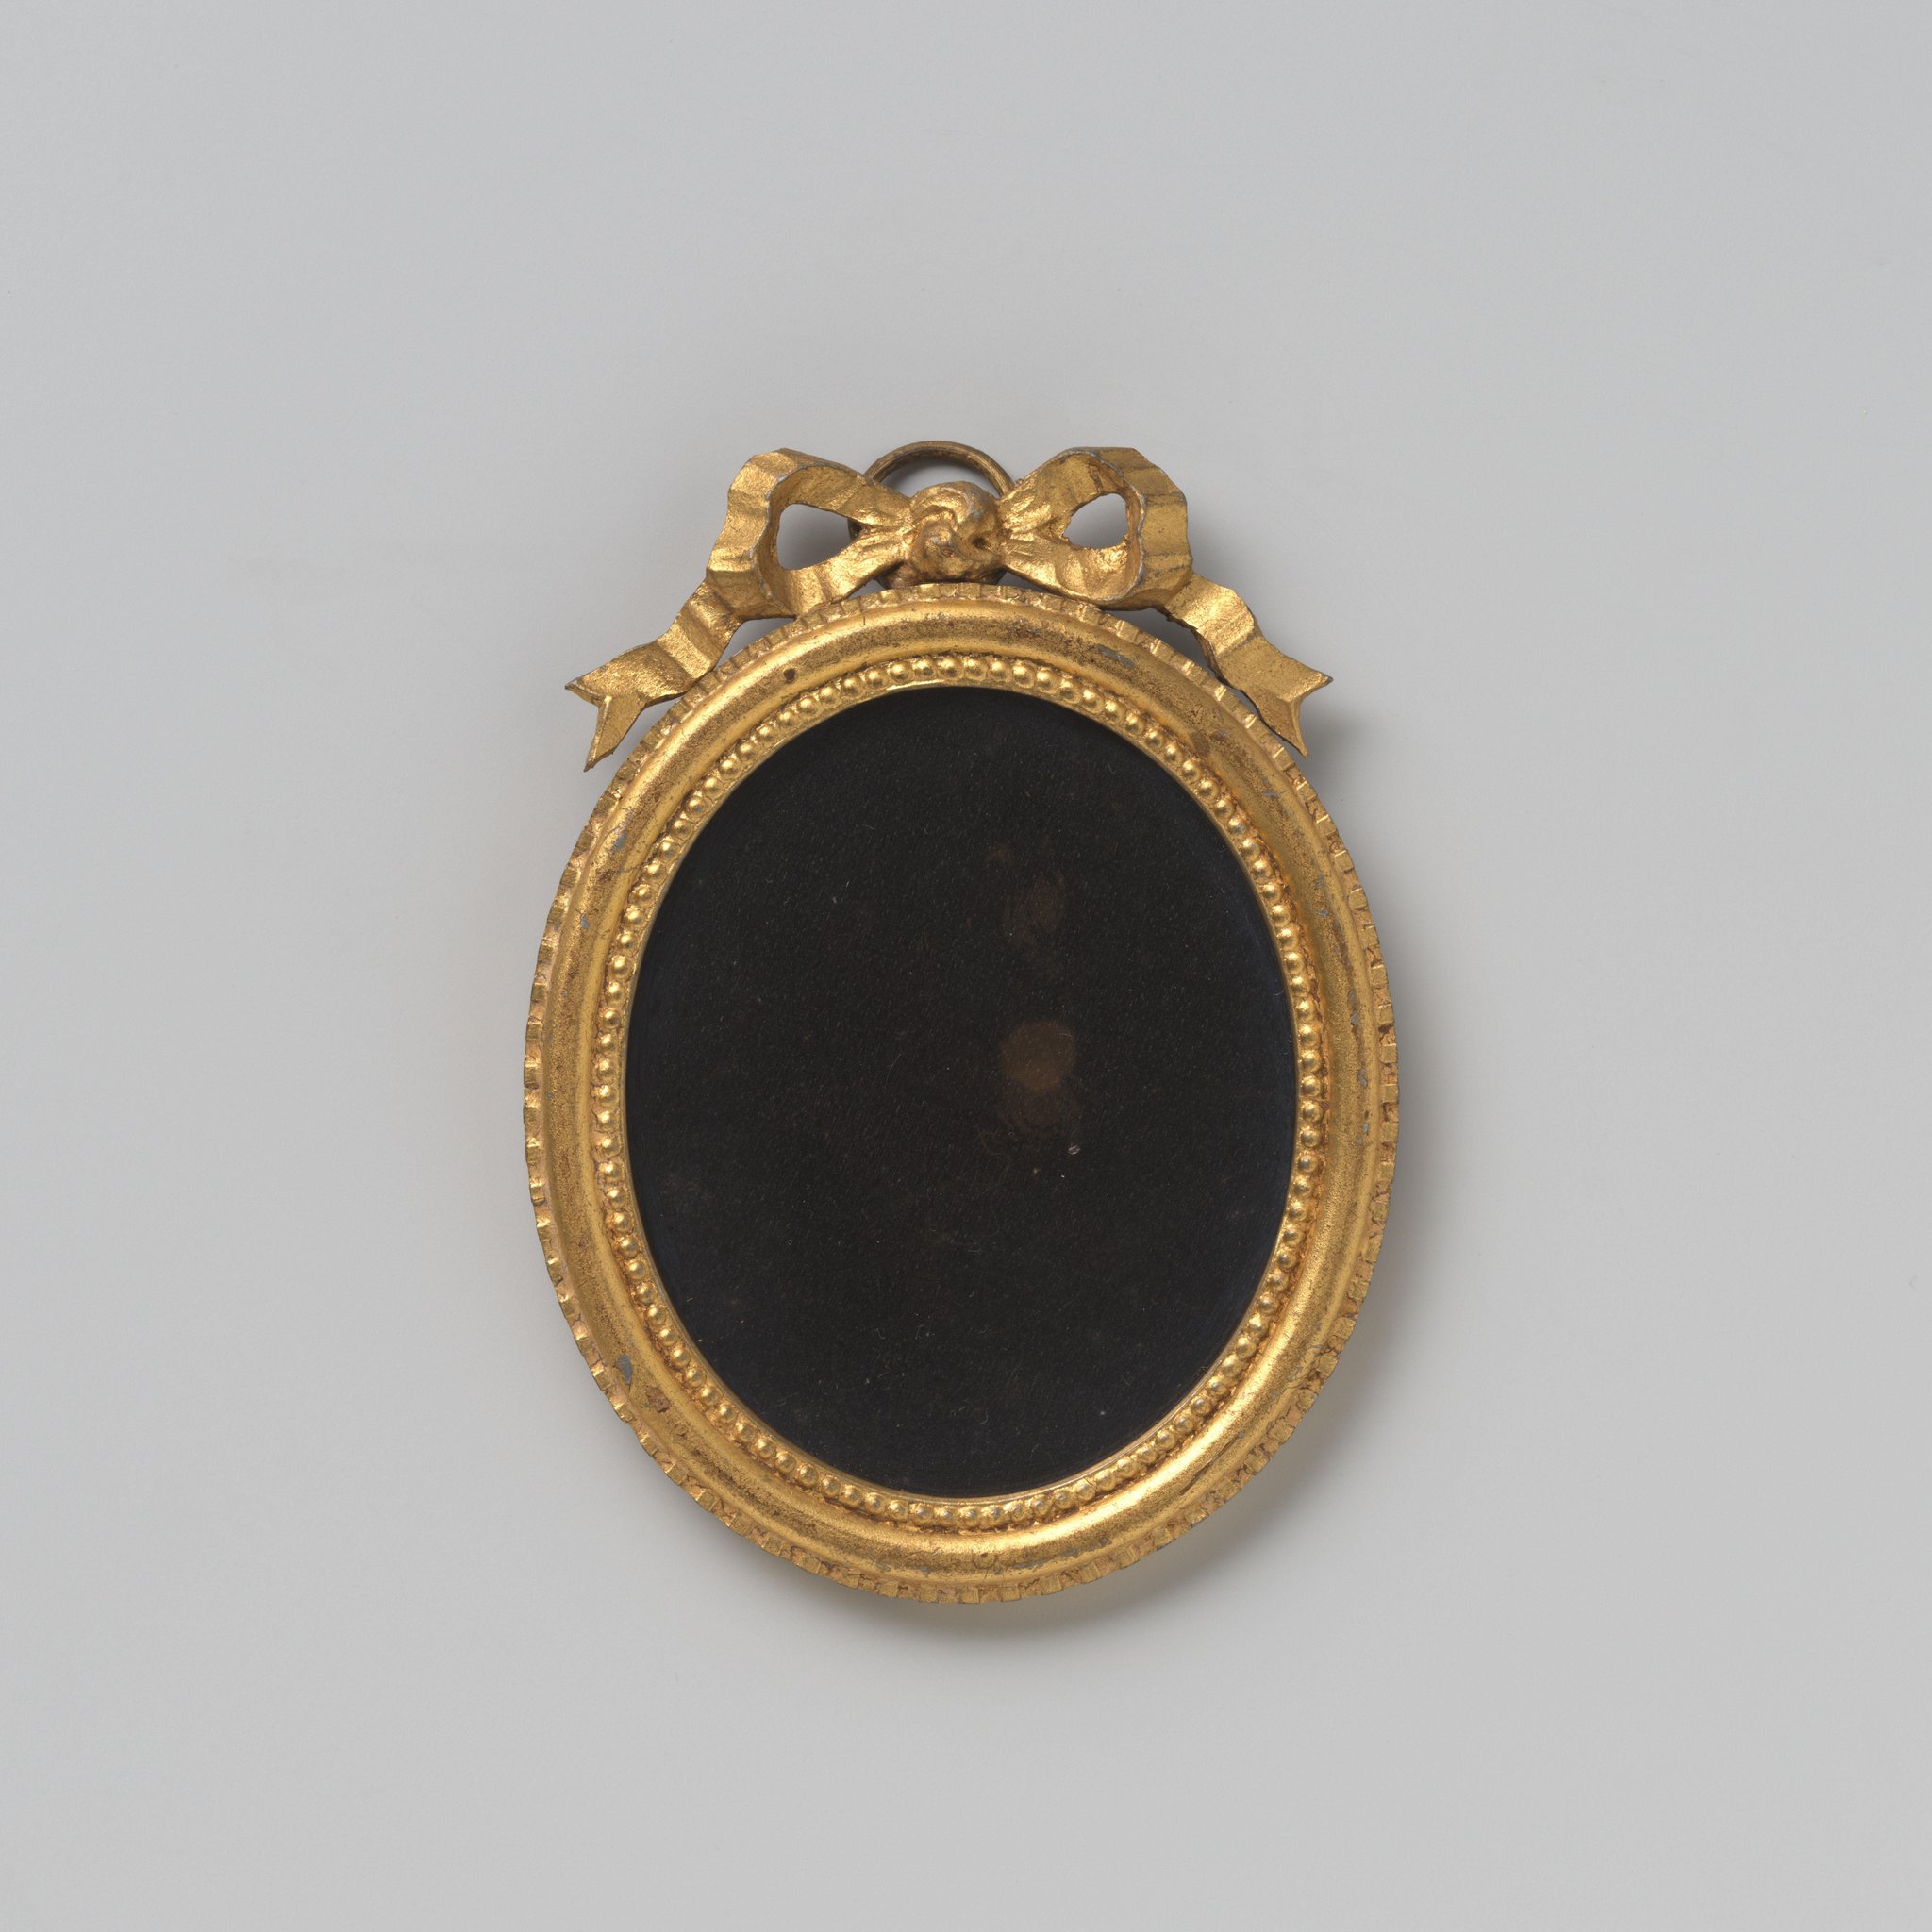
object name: frame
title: Lijst voor miniatuur van tin-loodlegering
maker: Anonymous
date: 1850-1899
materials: alloy, glass, gold, lead, paper, tin, velvet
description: Lijst voor miniatuur van tin-loodlegering, ovaal, in neo-klassicistische stijl met parel- en ribbelrand, bekroond door een strik. In de lijst een stuk zwarte fluweel.